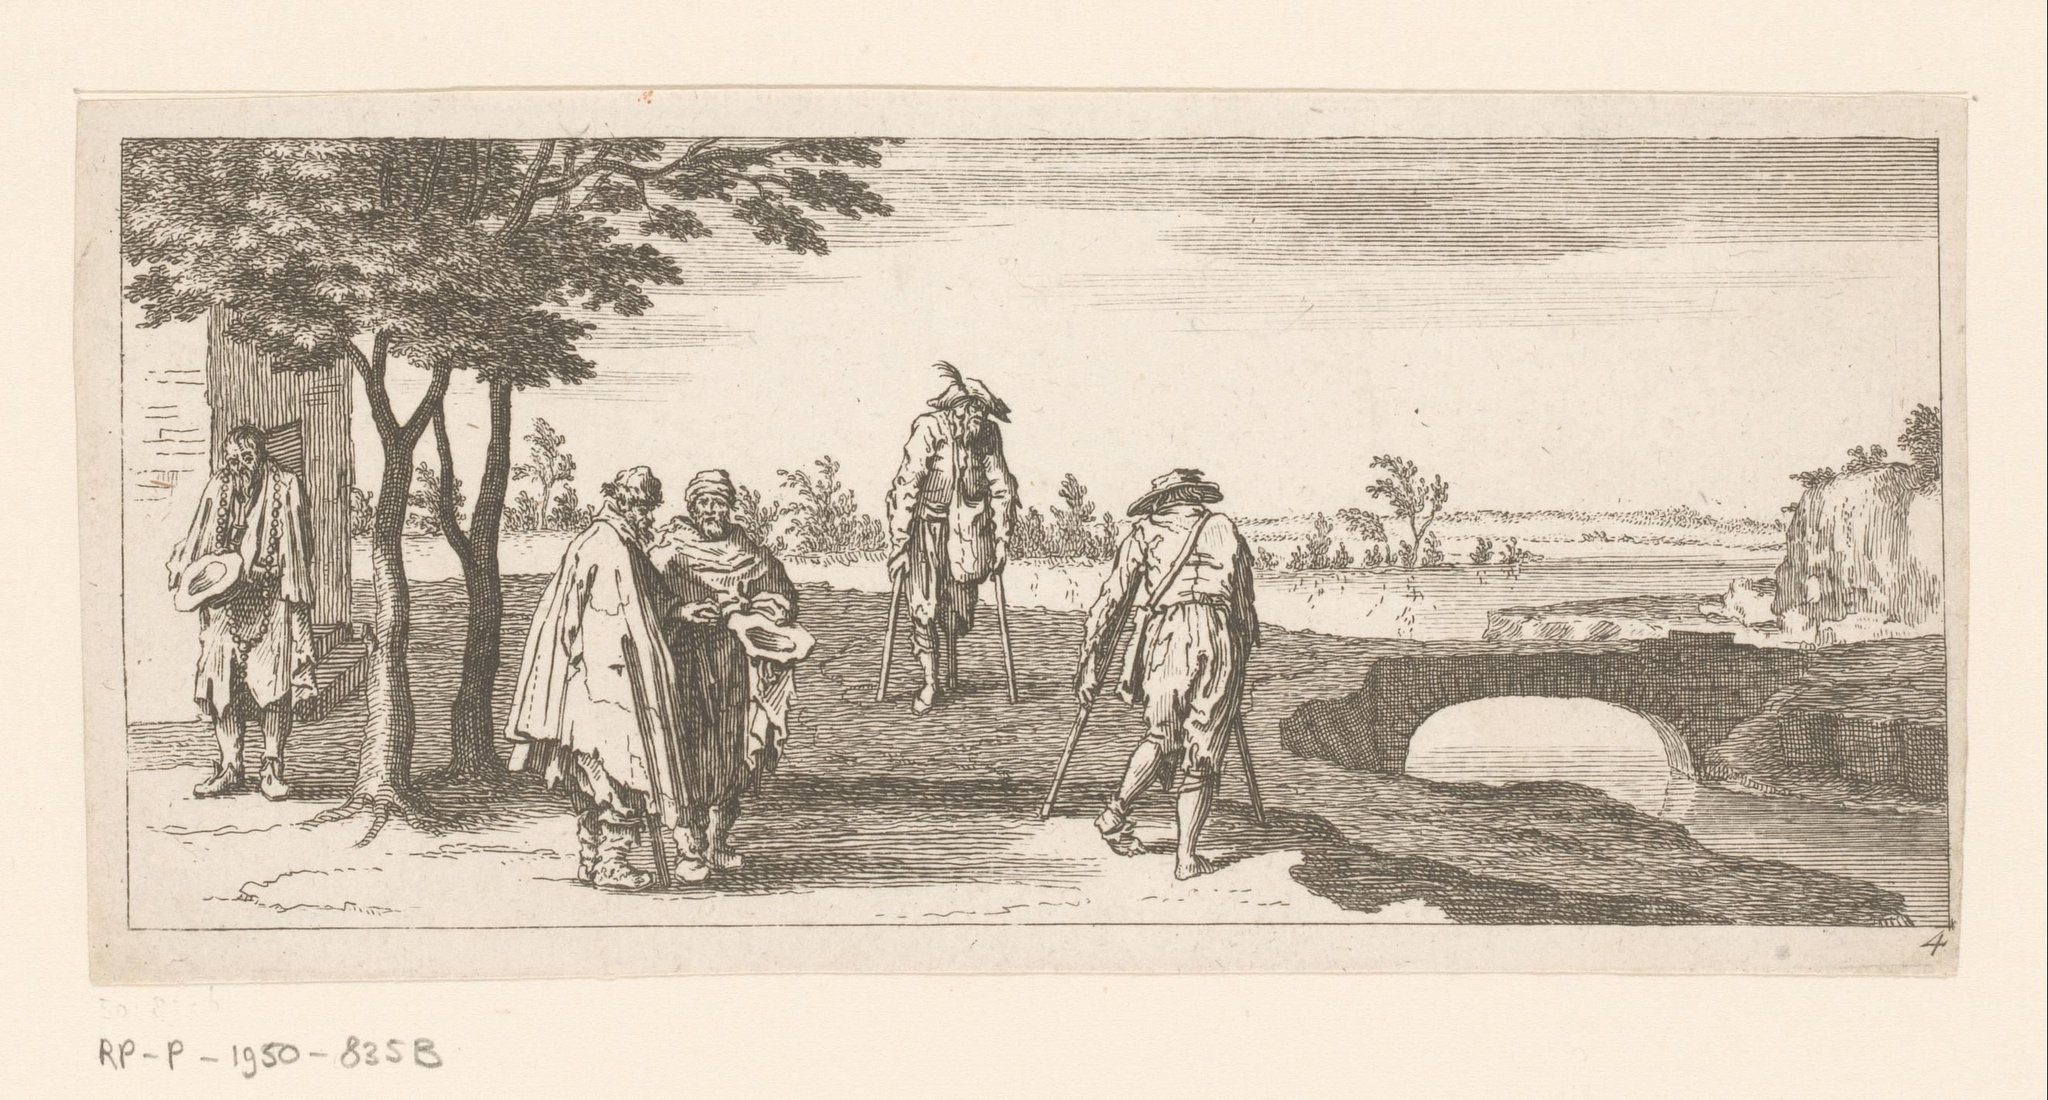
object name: print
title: Bedelaars en figuren met krukken bij een brug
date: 1638-1738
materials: paper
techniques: etching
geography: france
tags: crutches, beggar